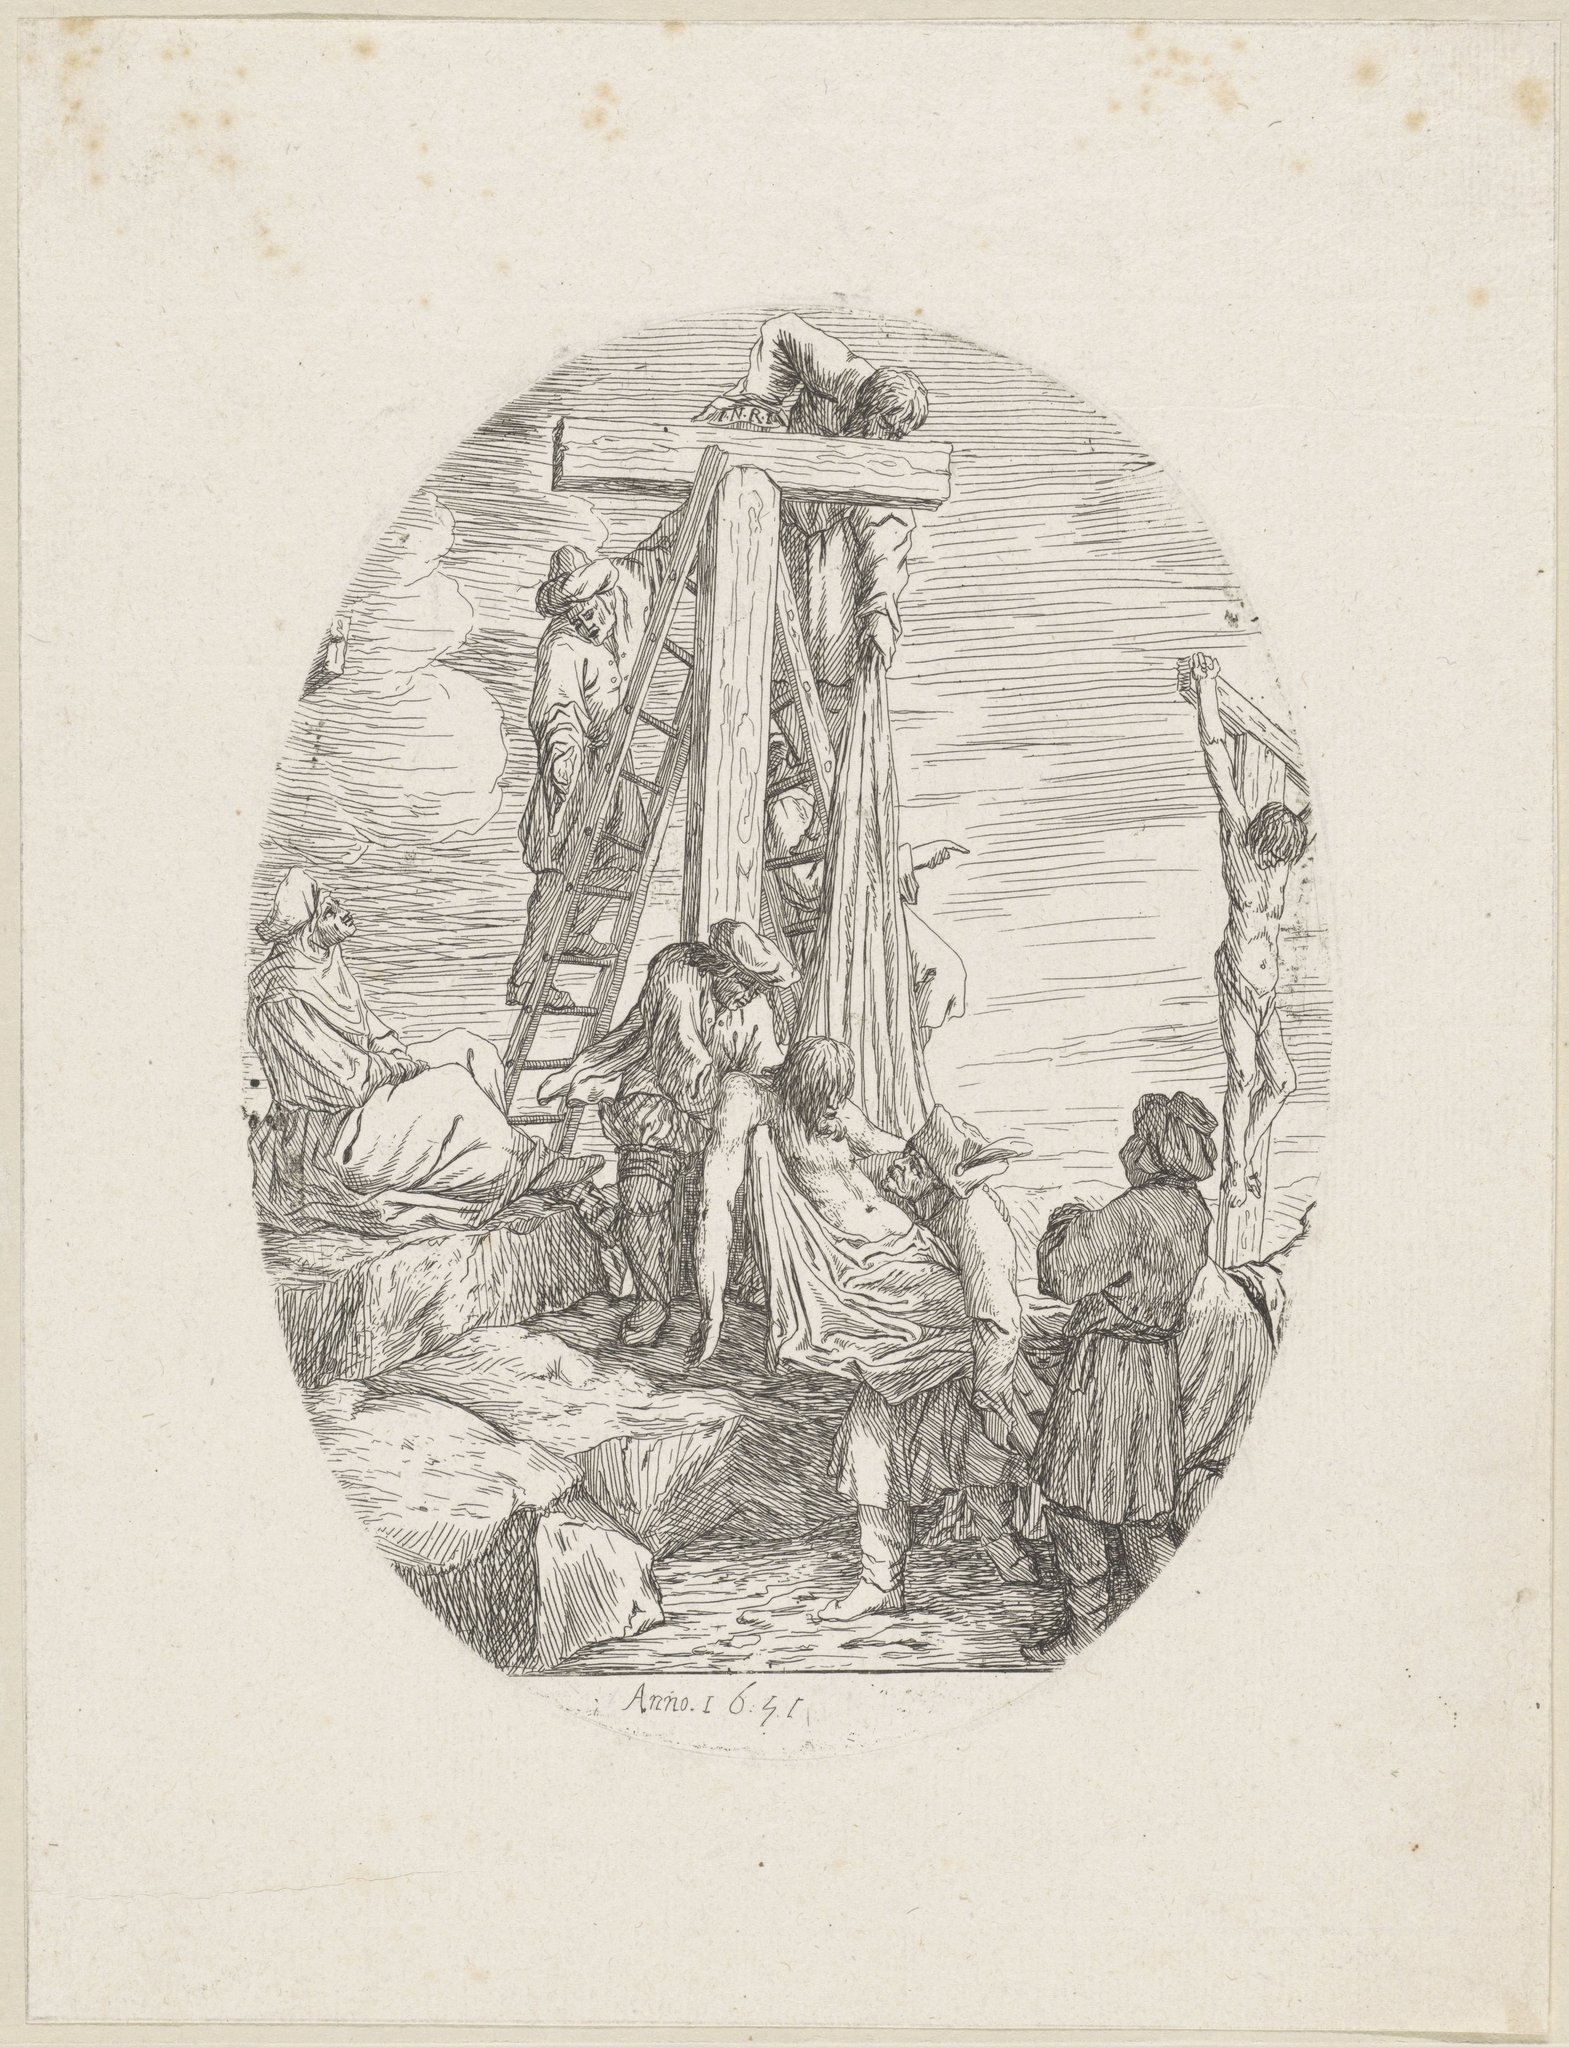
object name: print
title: Kruisafneming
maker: Anonymous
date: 1641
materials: paper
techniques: etching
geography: netherlands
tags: descent from the cross: christ is taken down from the cross, usually by nicodemus and joseph of arimathaea who are standing on the ladders (both arms of christ detached)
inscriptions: collector's mark: Lugt 240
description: Nikodemus en Josef van Arimatea halen de gestorven Christus van het kruis.